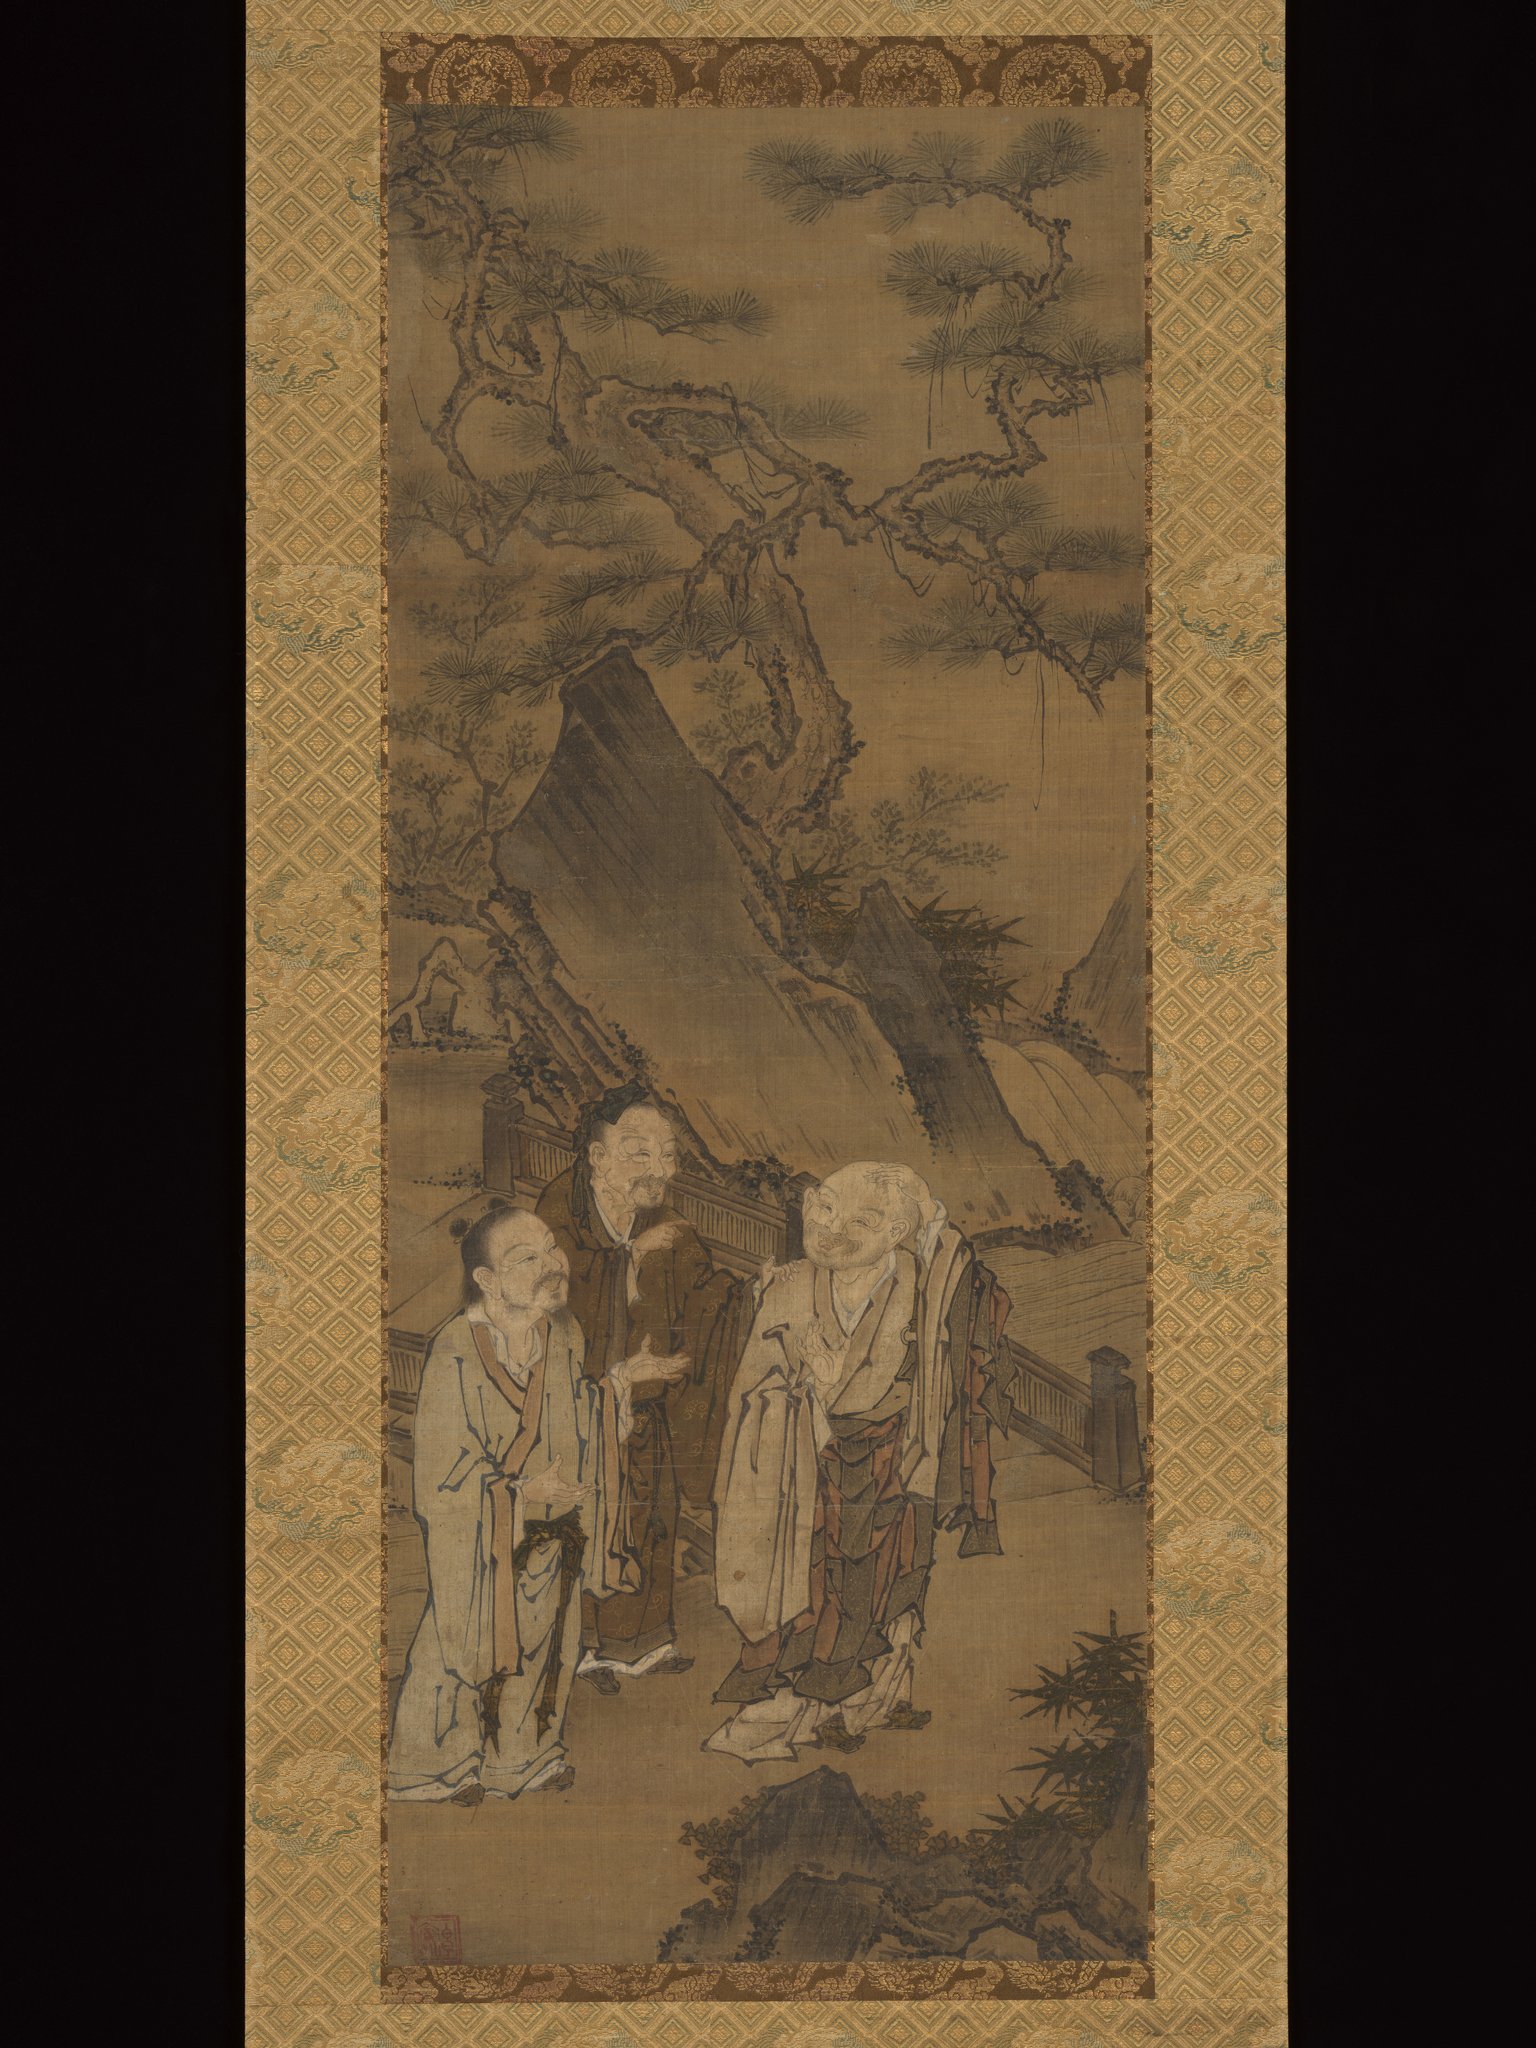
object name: hanging scroll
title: Three Laughers of Tiger Ravine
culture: japanese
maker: sekishō shōan 石樵昌安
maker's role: artist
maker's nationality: japanese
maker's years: 1534-1566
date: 1534-1566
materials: gold, ink, silk